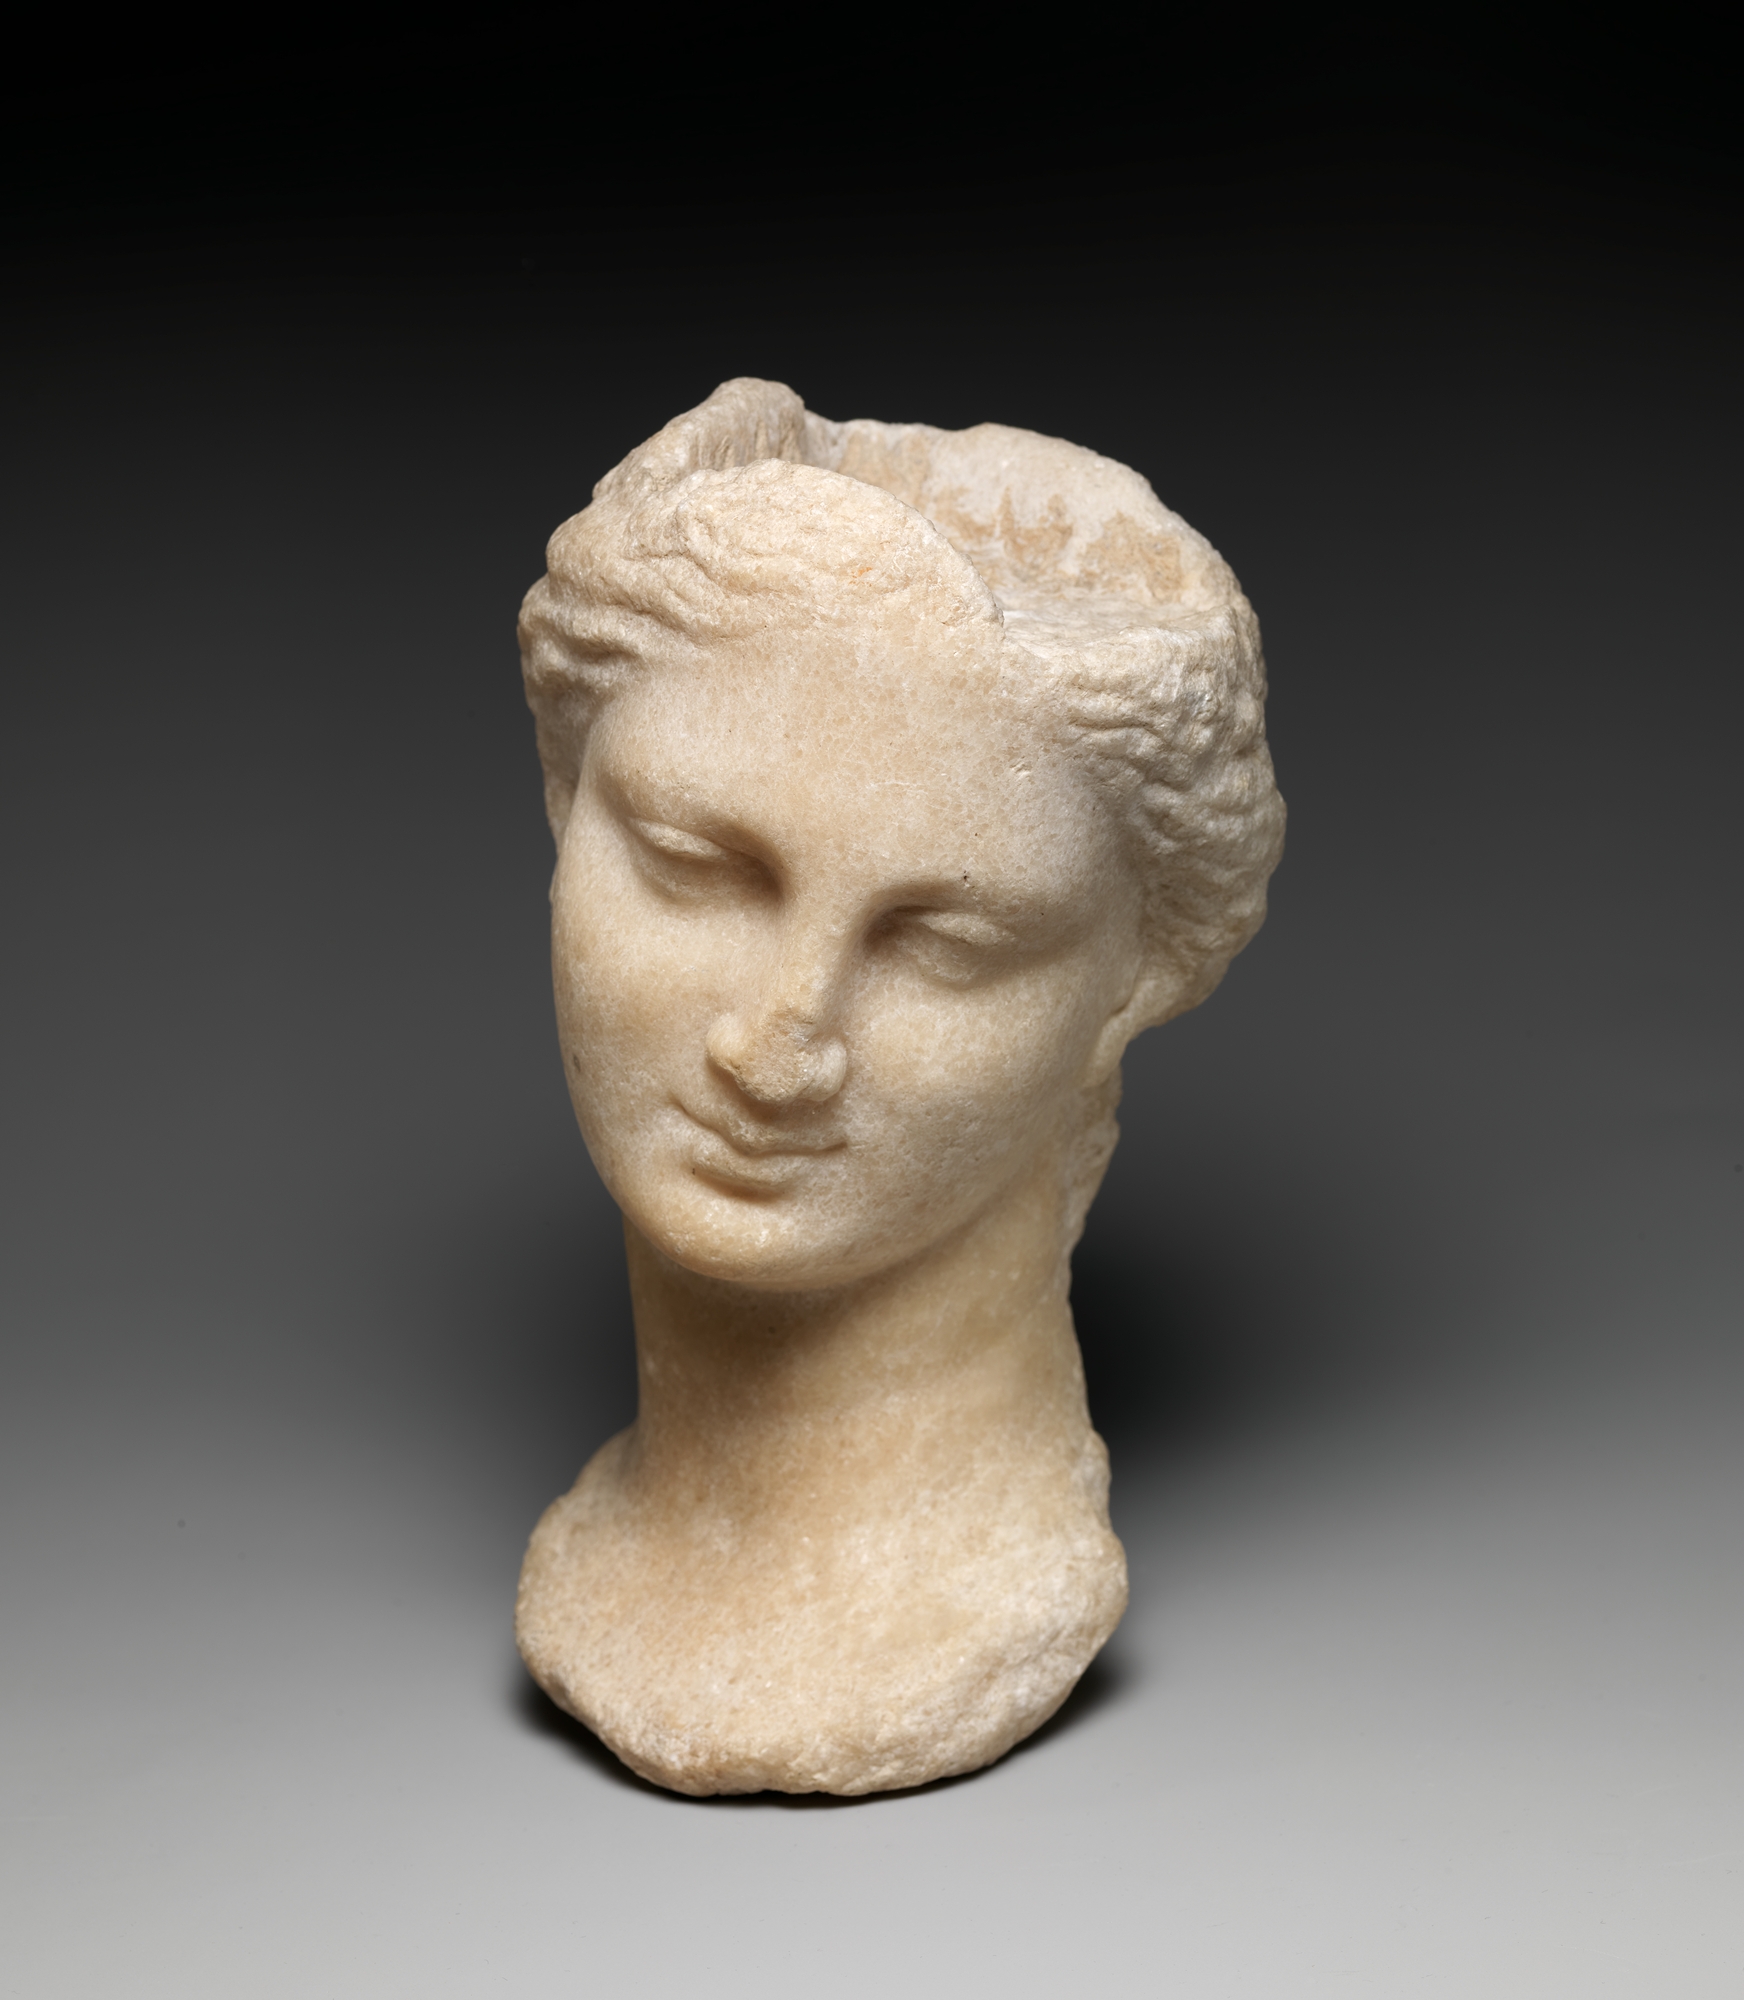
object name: head of a woman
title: Marble head of a girl from a small statue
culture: greek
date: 300-201 BCE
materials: marble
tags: heads,girls